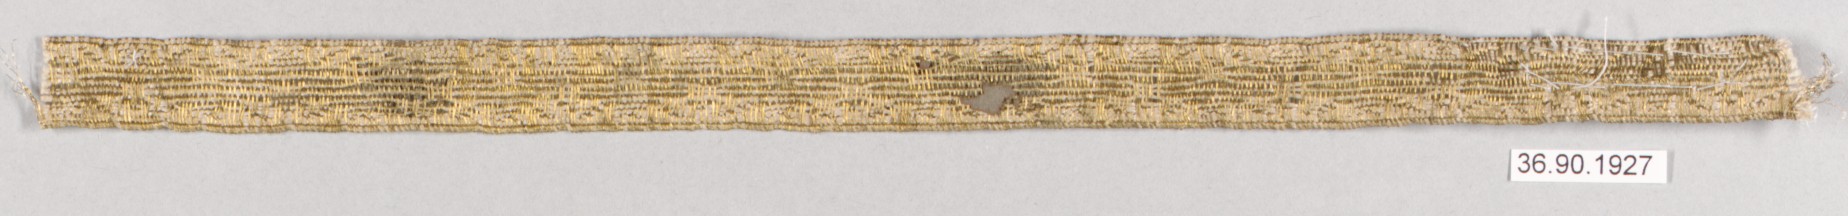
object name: galloon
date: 1601-1700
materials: metal thread